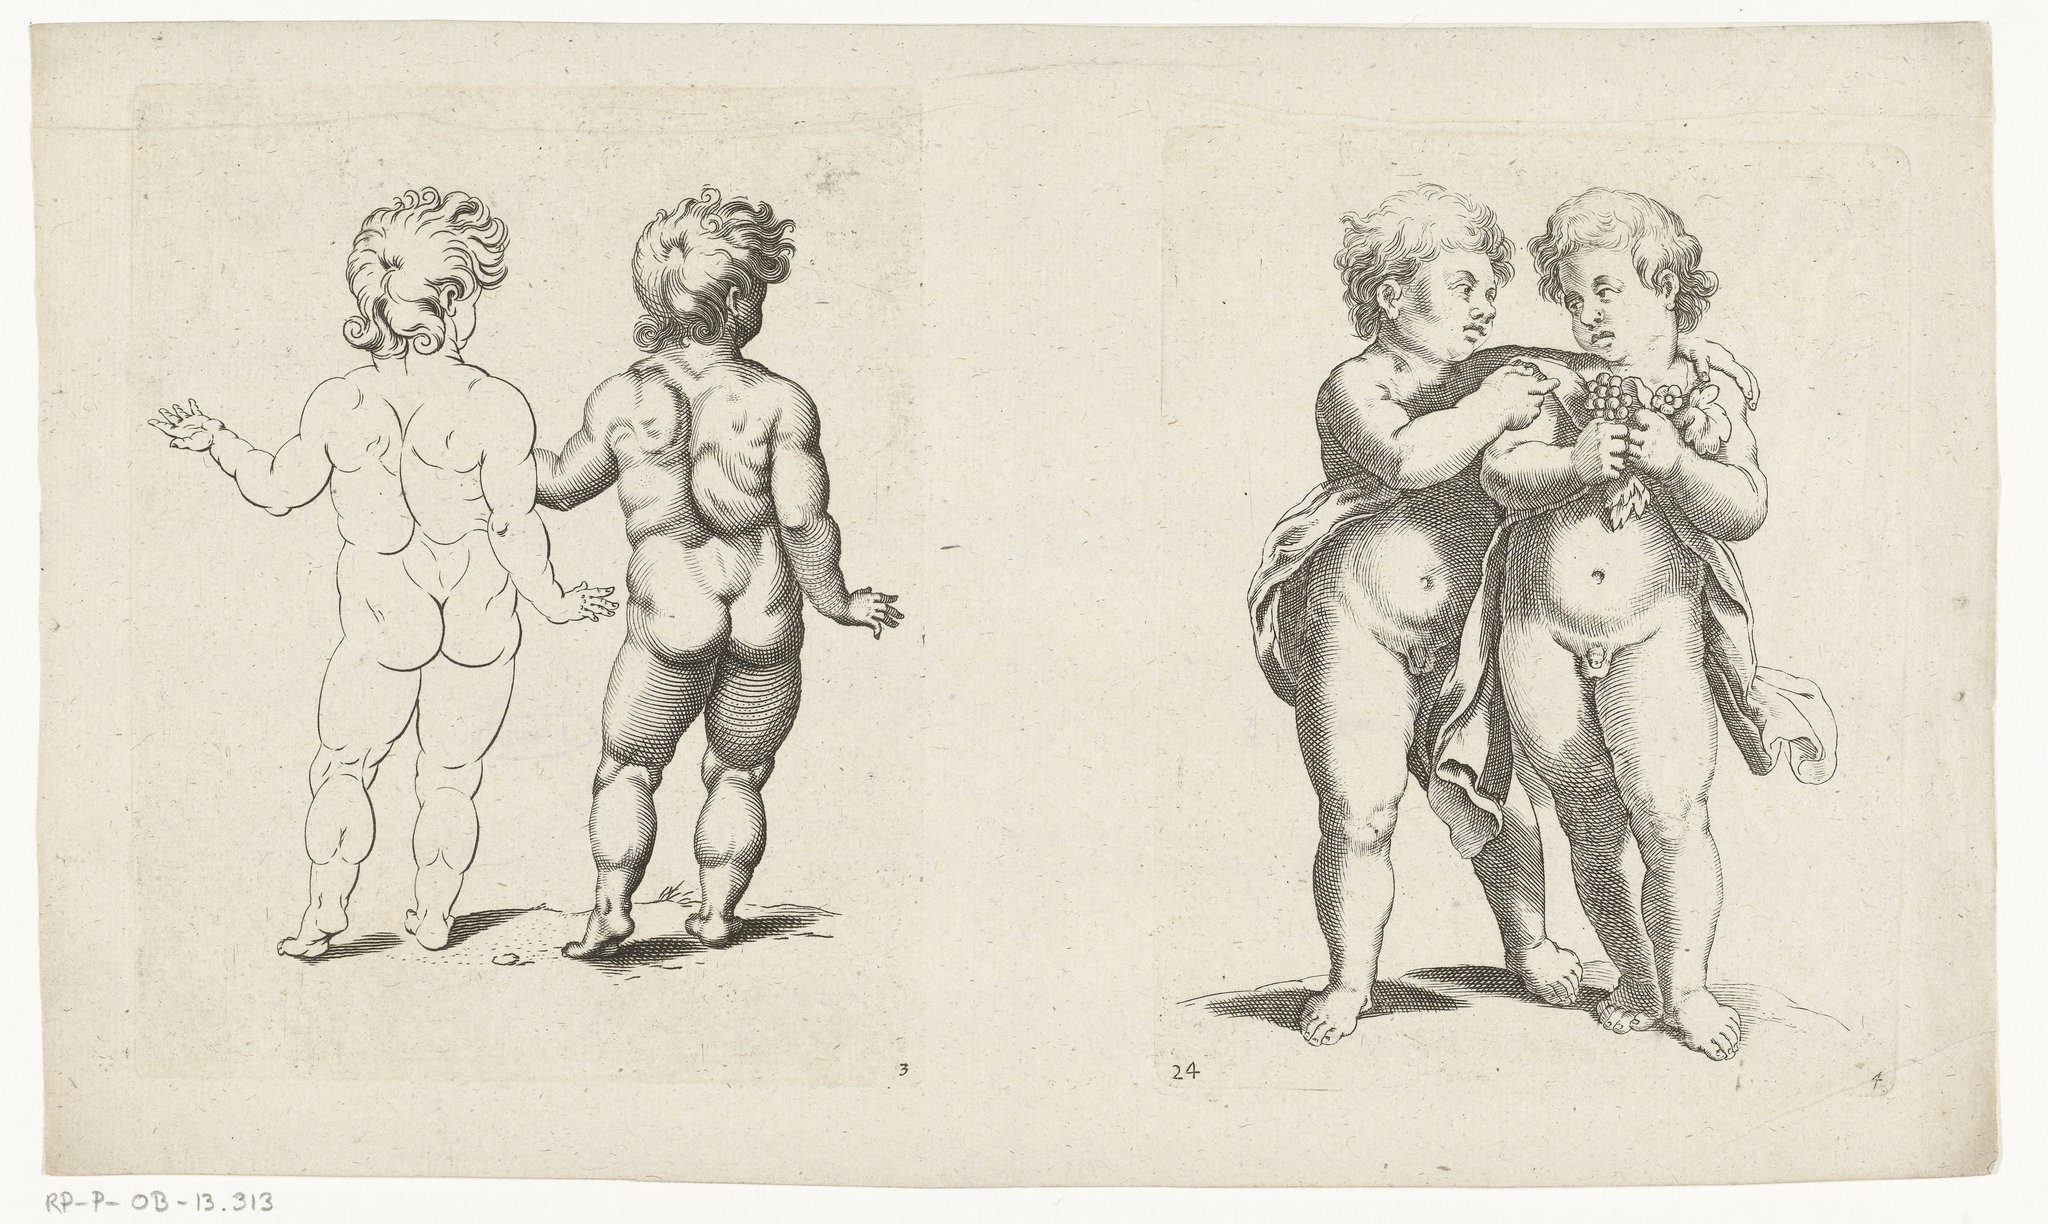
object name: print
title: Nieuw teecken-boeck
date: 1671-1726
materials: paper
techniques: engraving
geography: amsterdam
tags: cupids: 'amores', 'amoretti', 'putti'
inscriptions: collector's mark: Lugt 2228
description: Niet versneden blad met twee voorstellingen. Links twee naakte putti van achteren gezien, rechts twee putti waarvan de ene de andere een doek om de schouders legt. Rechtsonder genummerd 3 en 4, de rechte voorstelling linksonder genummerd 24. Blad voor "Nieuw teecken-boeck. Tweede deel".